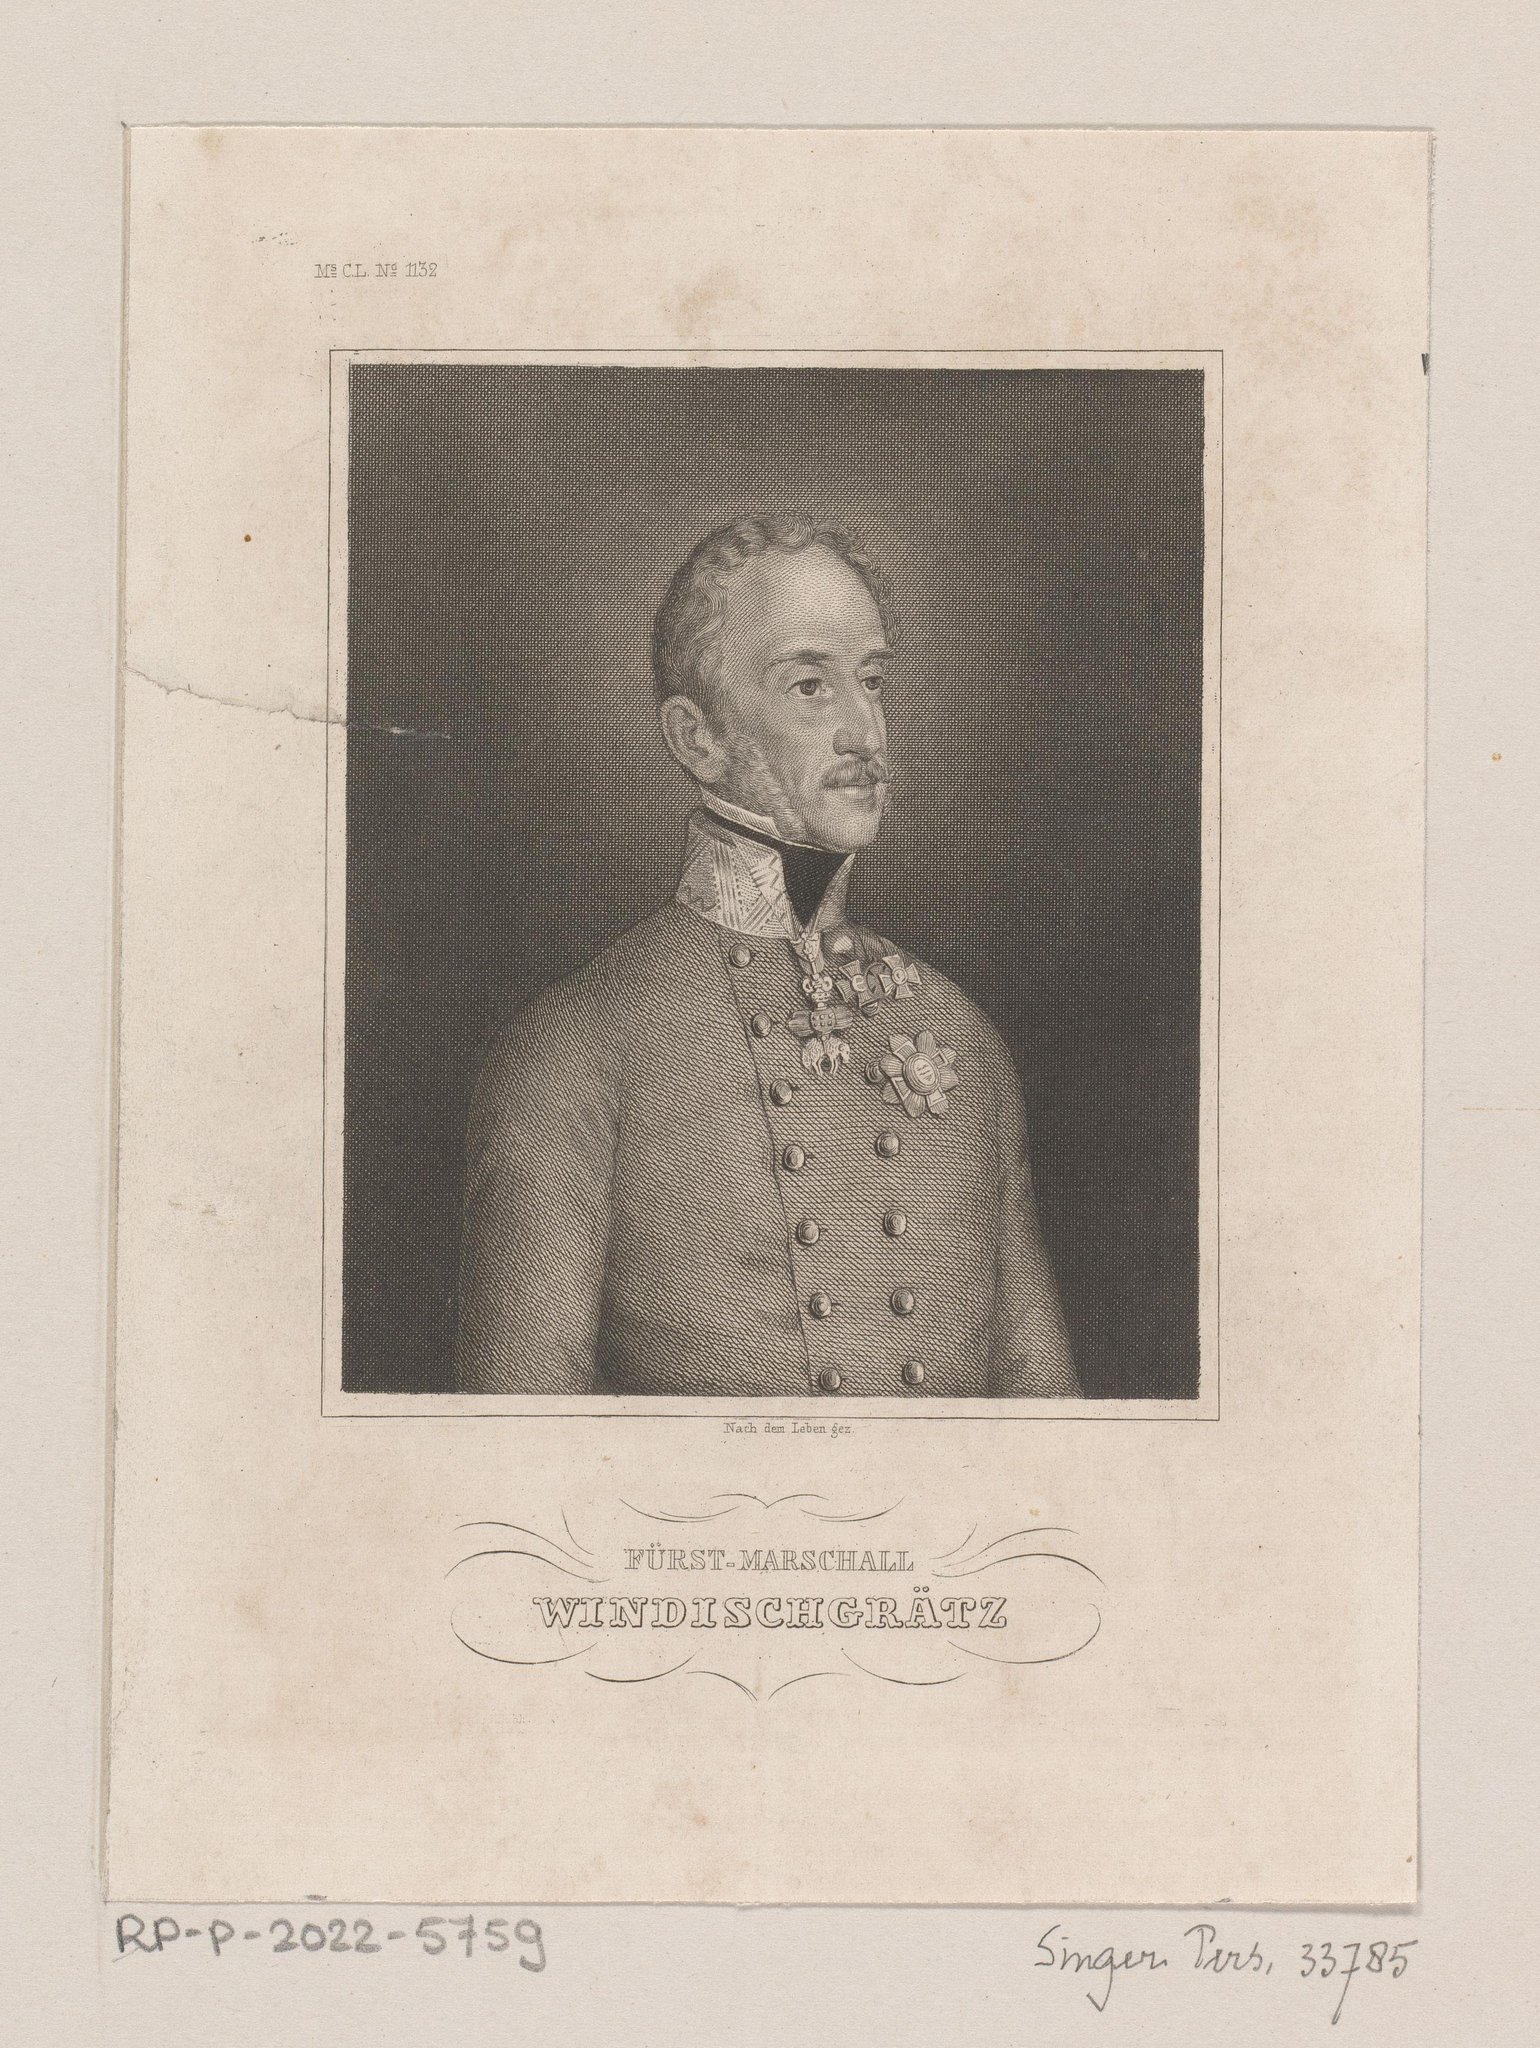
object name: print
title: Portret van Alfred I zu Windisch-Graetz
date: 1839-1855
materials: paper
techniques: engraving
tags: vienna, commander-in-chief, general, marshal, historical persons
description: Prent waarschijnlijk uit: Meyer, Joseph. Das große Conversations-Lexikon für die gebildeten Stände. 52 dln. Hildburghausen: Bibliographisches Institut, [1839-1855].